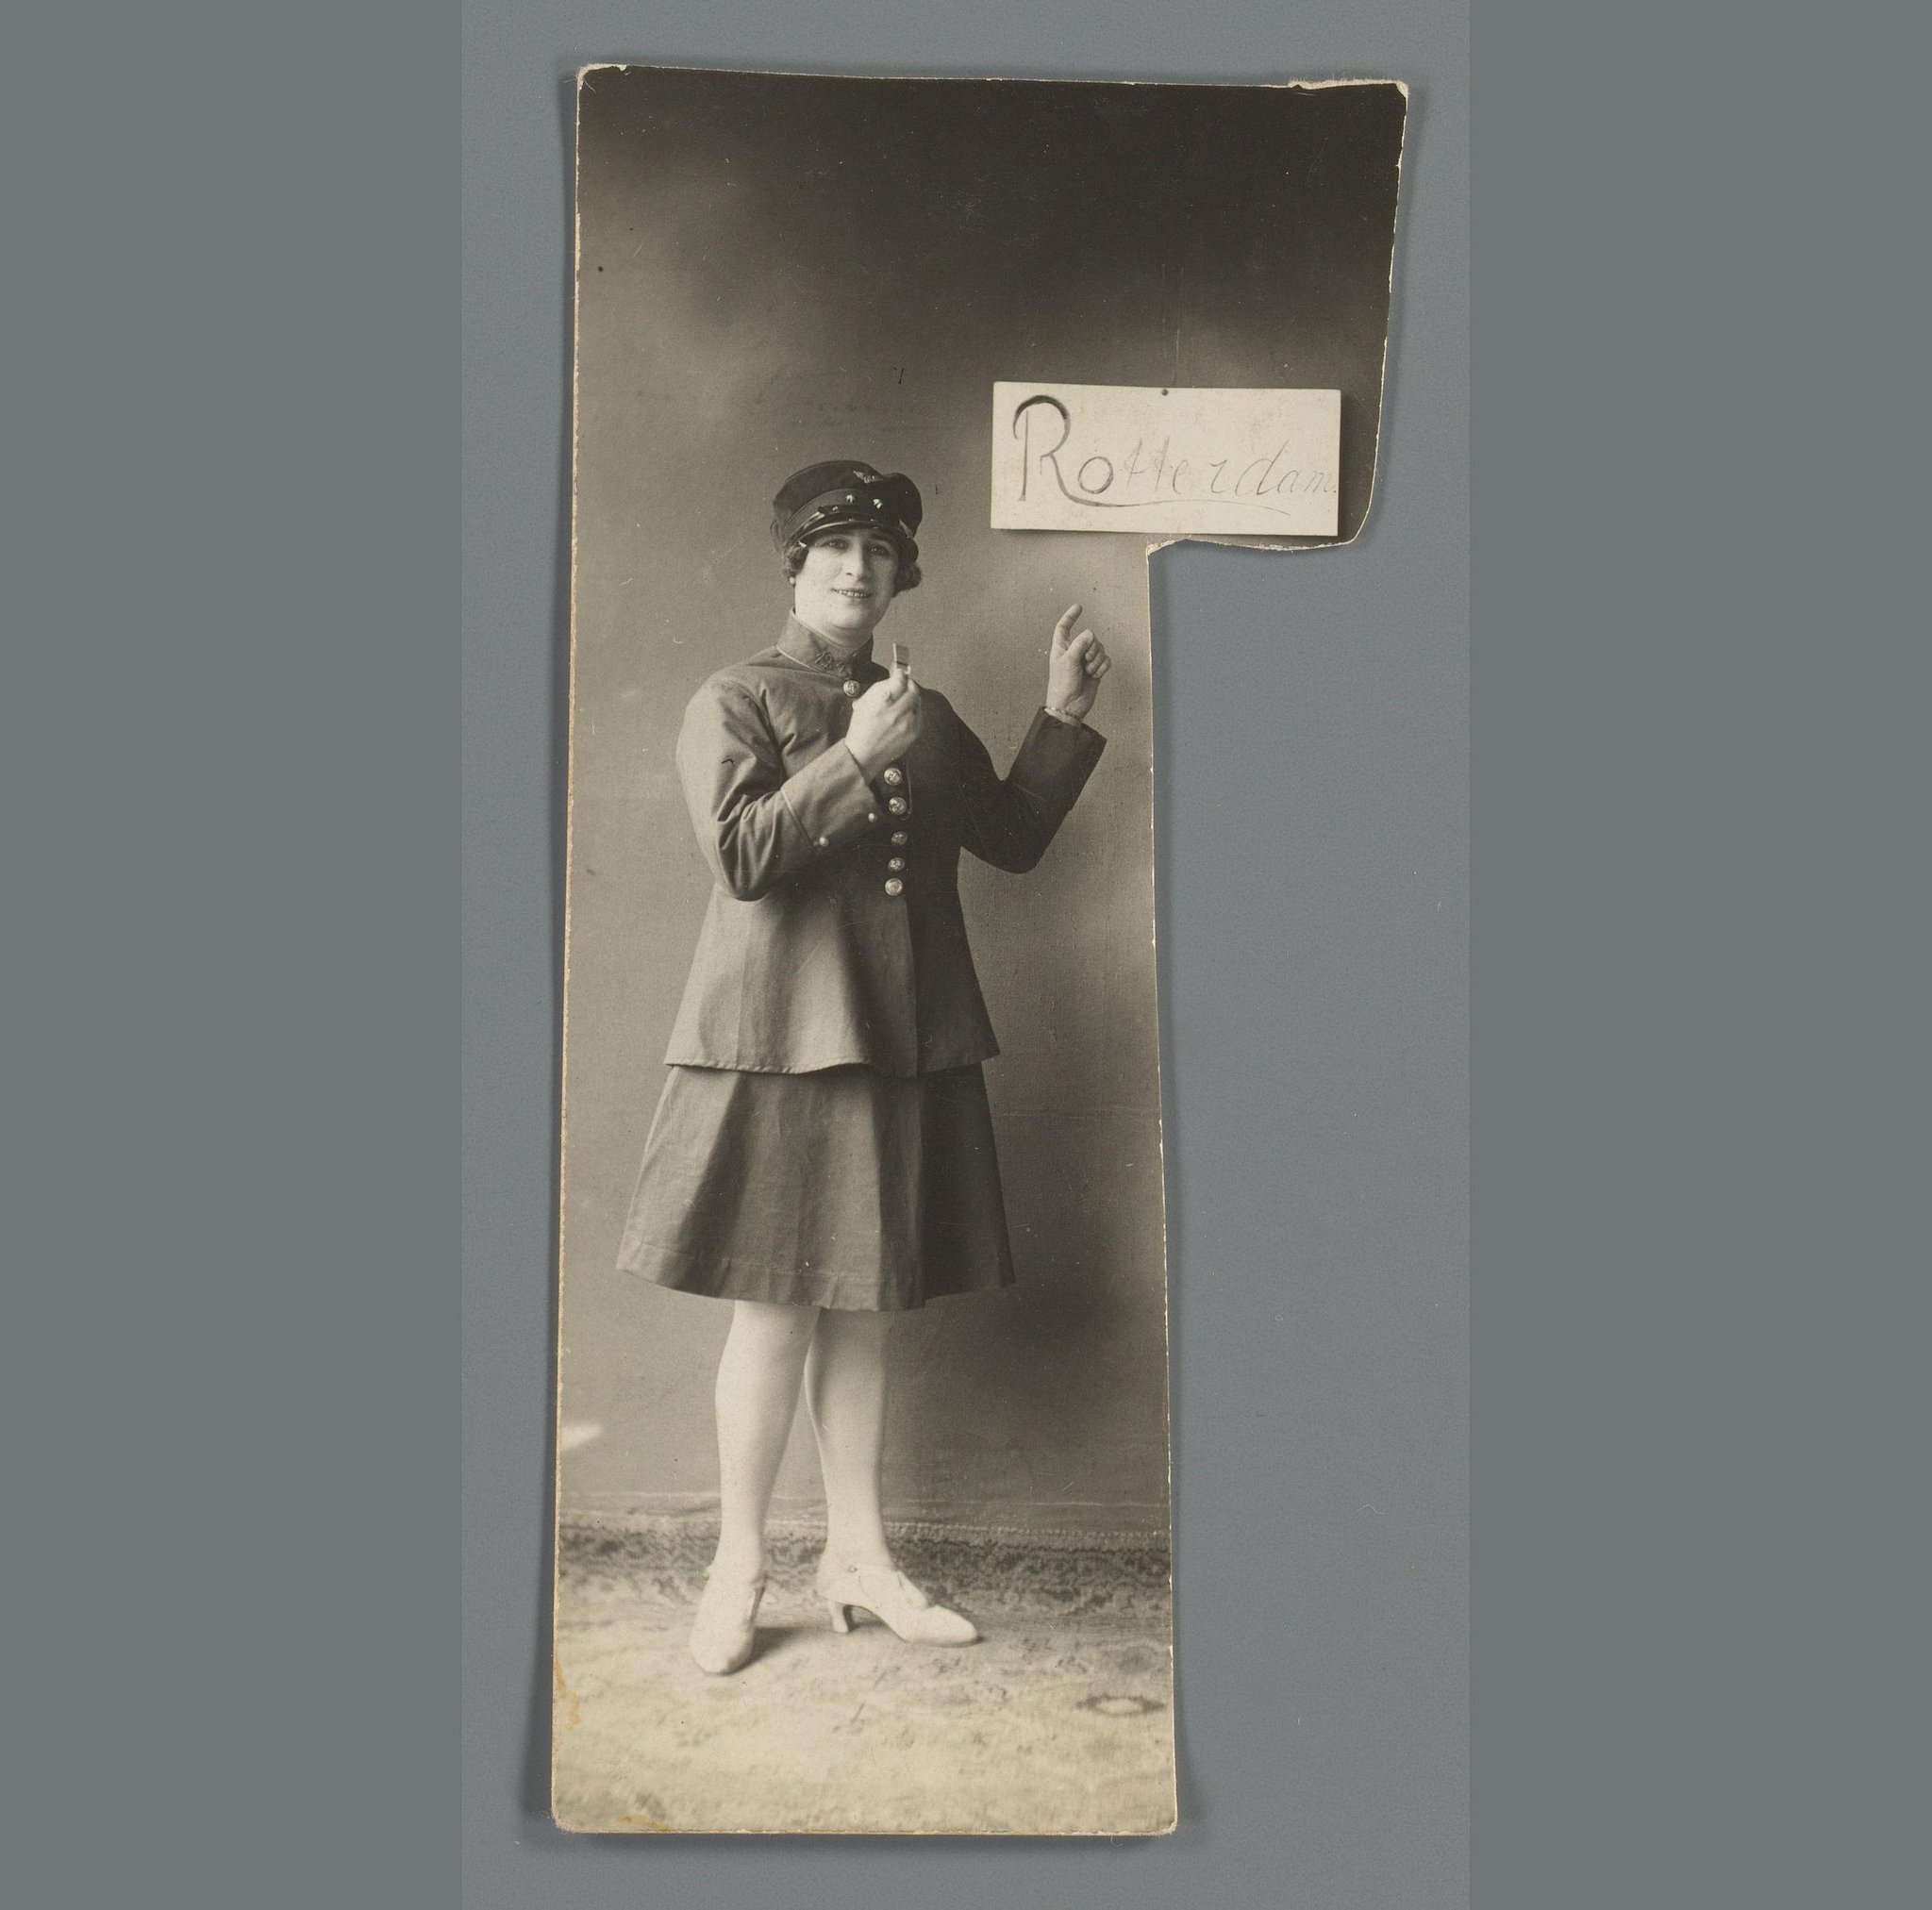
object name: photograph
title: Portret van Cato Merks in conducteursuniform bij een bord Rotterdam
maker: Anonymous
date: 1900-1930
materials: paper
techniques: gelatin silver print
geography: netherlands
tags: historical persons - bb - woman, portrait of cabaret-artiste, netherlands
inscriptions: inscription: ‘Cato Merks’